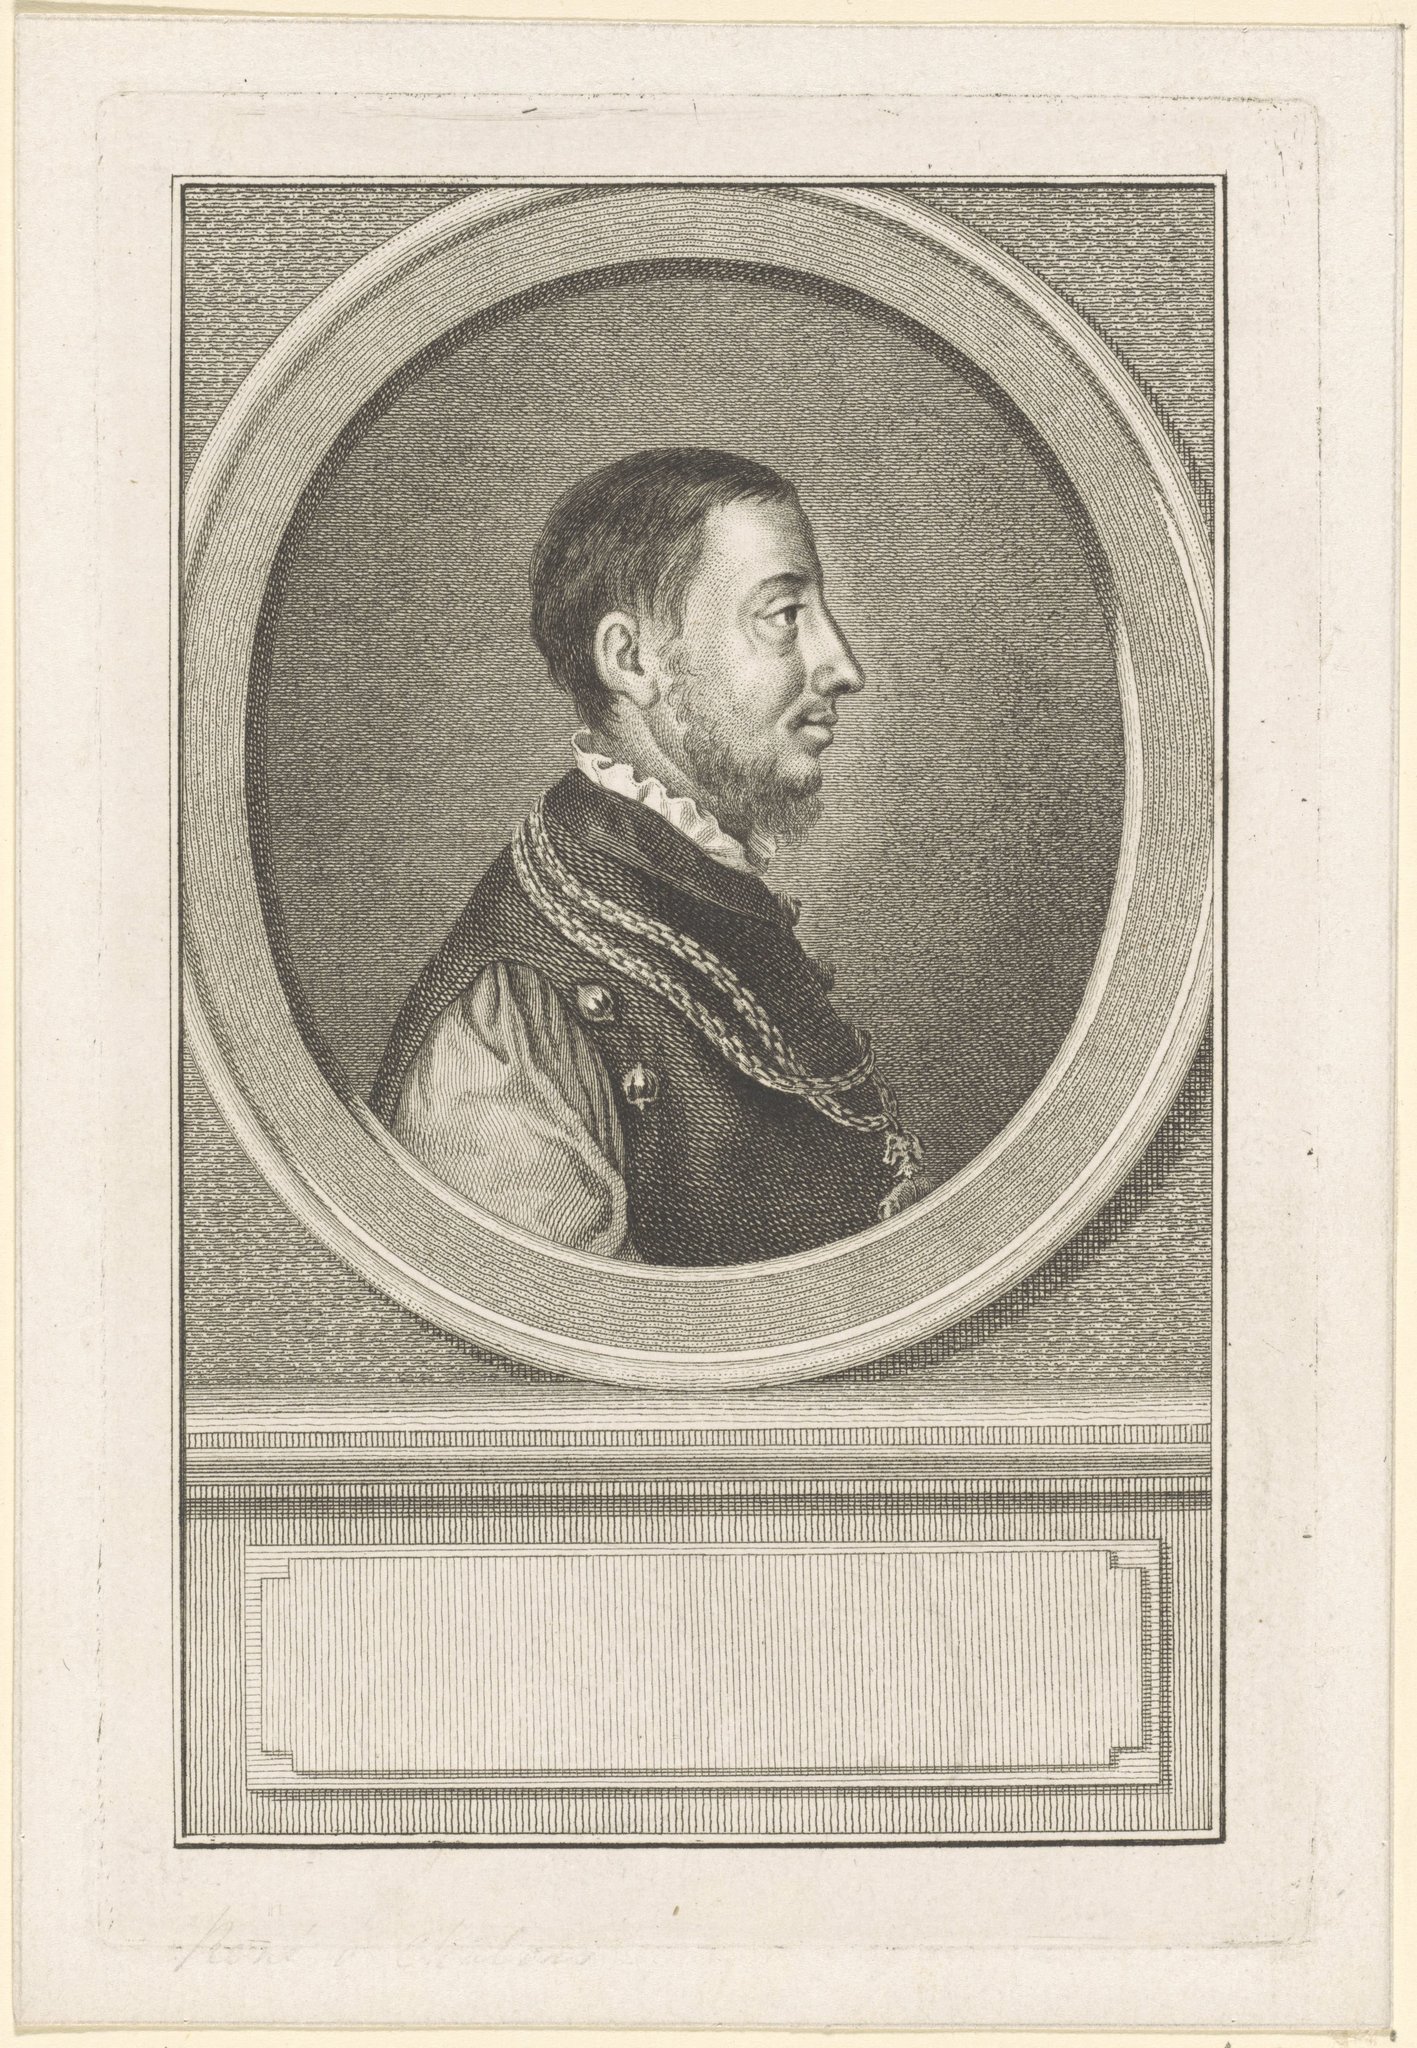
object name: print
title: Portret van René van Châlon, prins van Oranje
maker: reinier vinkeles (i)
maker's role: draughtsman, print maker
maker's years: 1741-1816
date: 1757-1803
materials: paper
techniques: engraving, etching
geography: amsterdam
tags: knighthood order of the golden fleece - insignia of a knighthood order, e.g.: badge, chain (with name of order)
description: De hier vermelde titel verwijst naar de hoogst verkregen titel van de geportretteerde, niet per se naar de titel die de geportretteerde op deze voorstelling draagt.